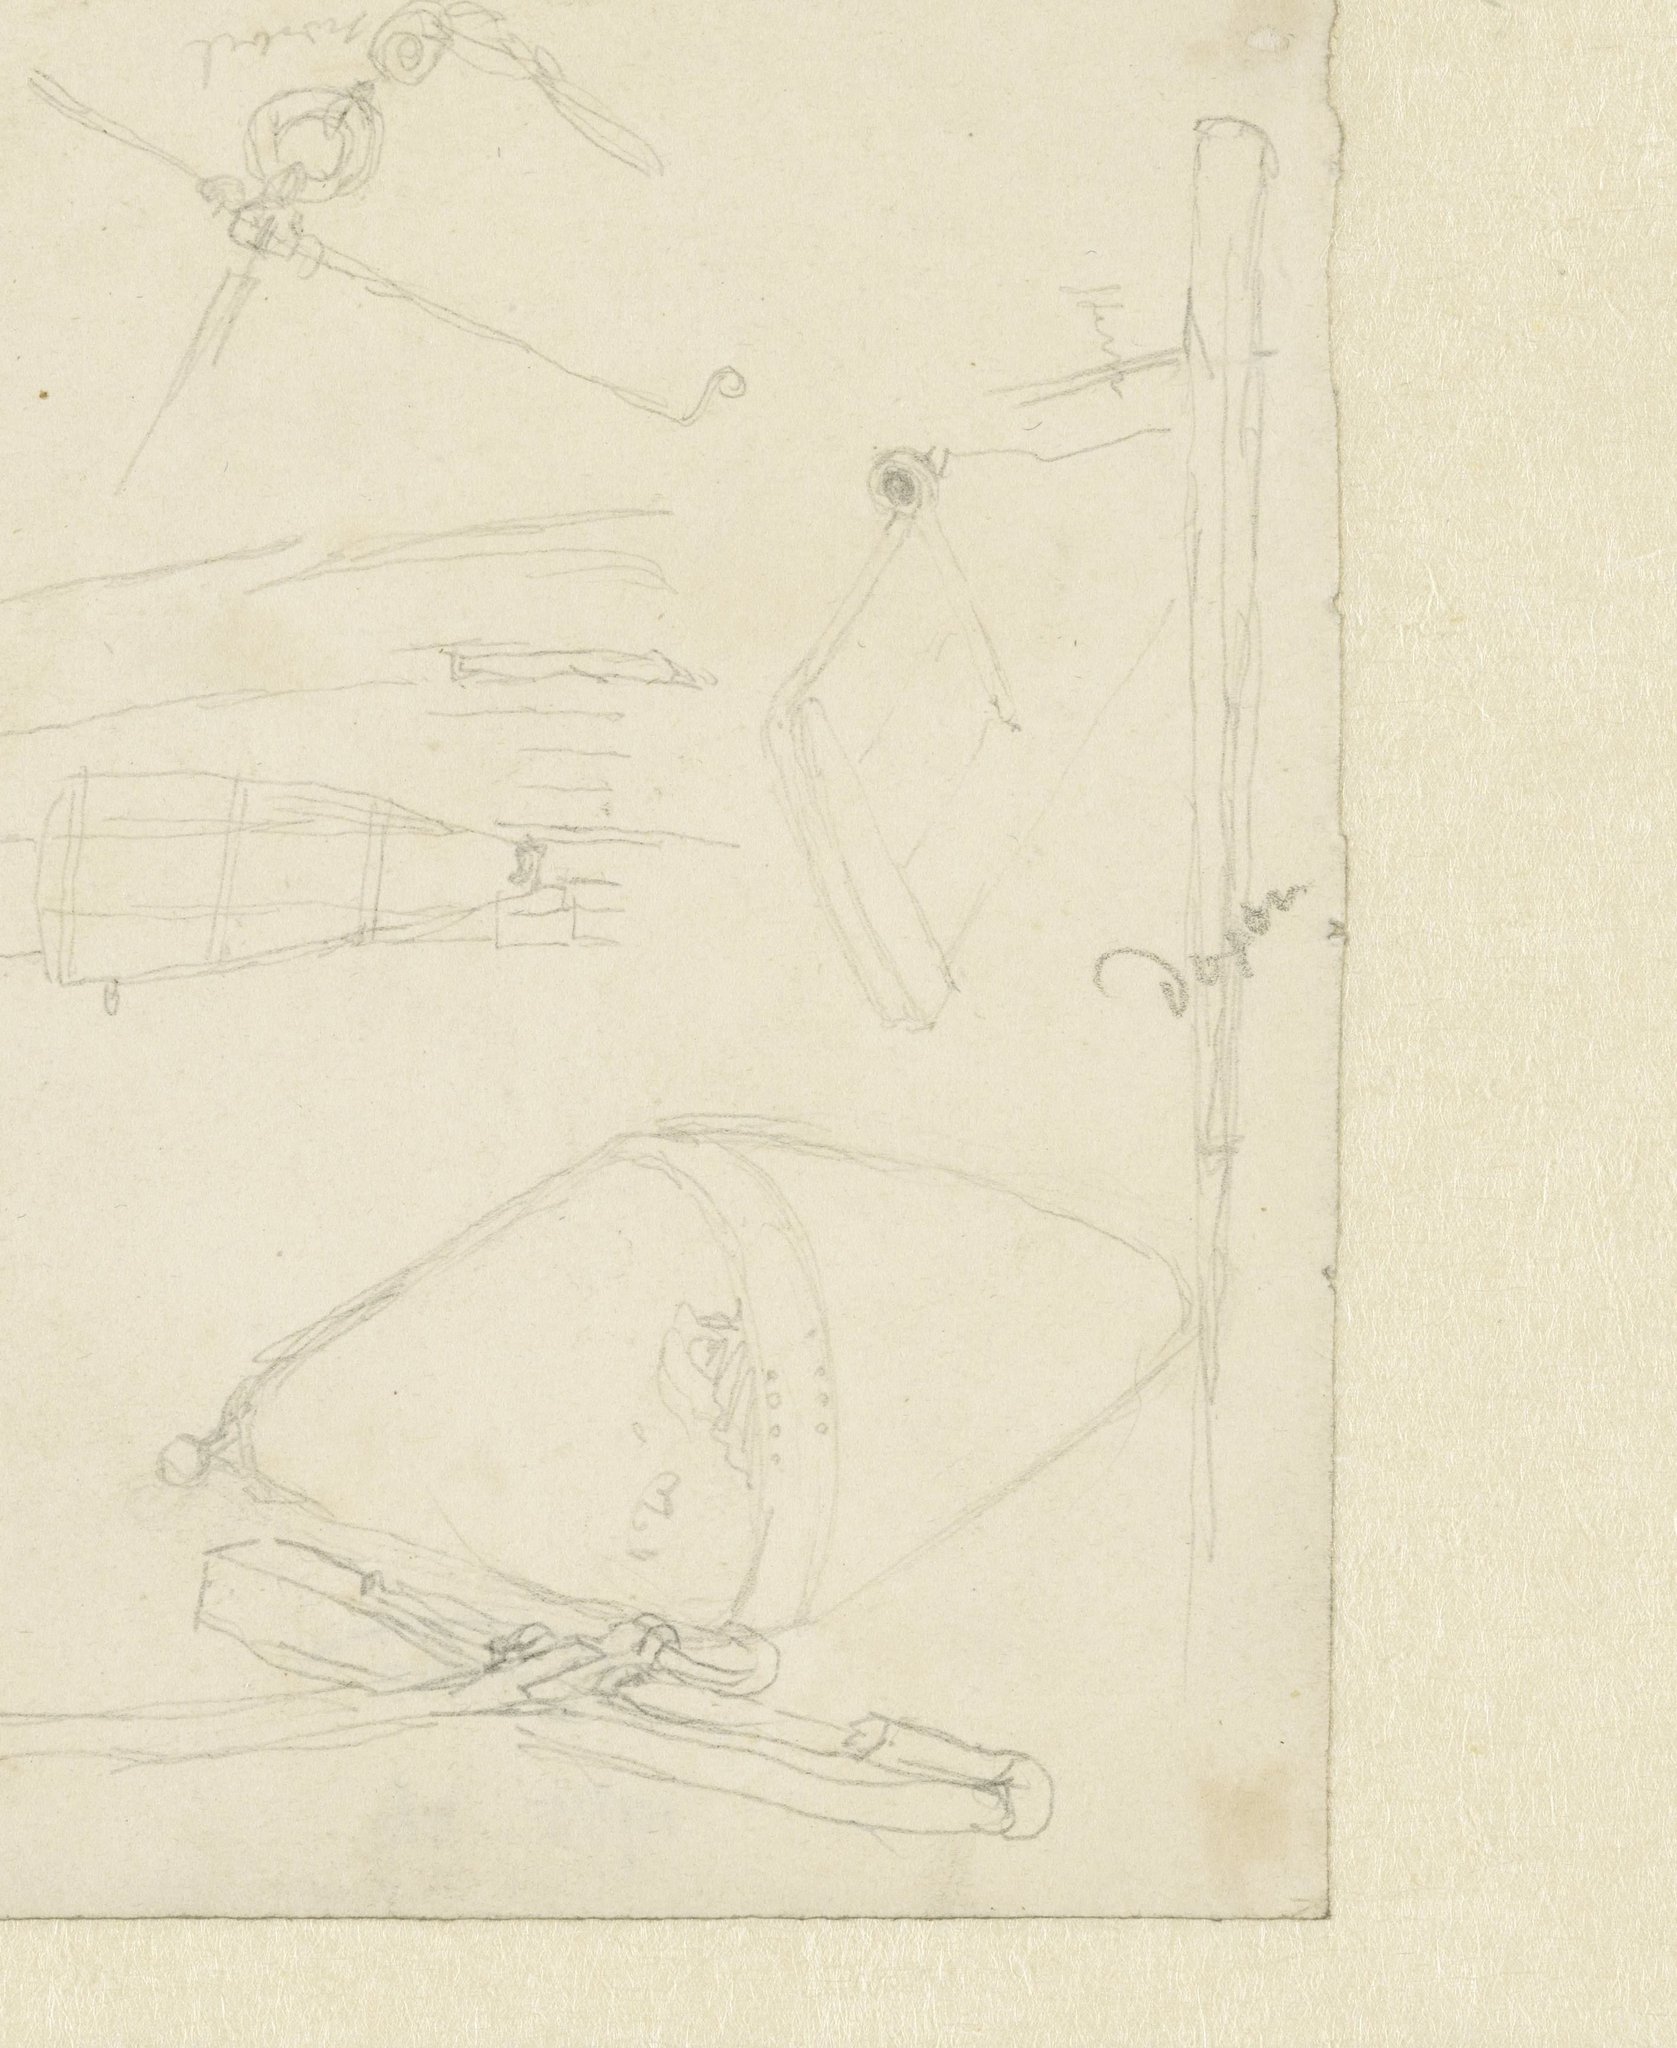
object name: drawing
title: Romp van een schip met een zwaard, een boei en onderdelen van een anker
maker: john linnell (ii)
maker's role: draughtsman, print maker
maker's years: 1792-1882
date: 1802-1882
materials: paper, pencil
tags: parts of ship's exterior, beacon, parts of ship's exterior: anchor